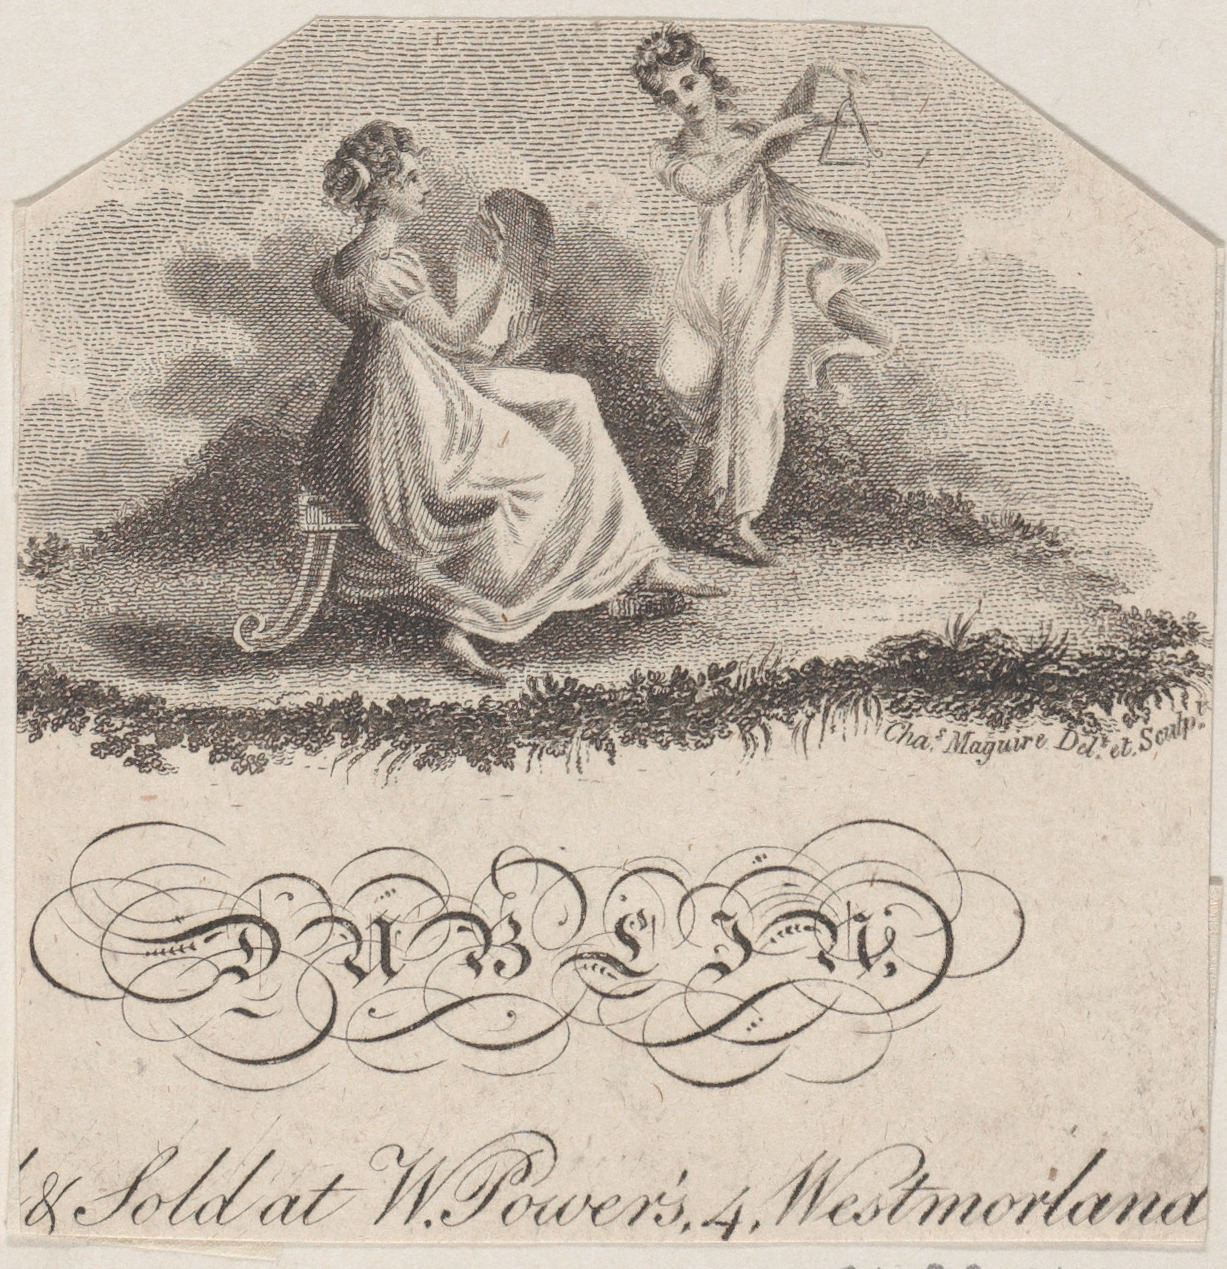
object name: print, trade card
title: Trade Card for W. Powers, Printer and Publisher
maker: anonymous, british, 19th century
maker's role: artist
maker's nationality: british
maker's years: 1800-1900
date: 1801-1900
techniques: engraving